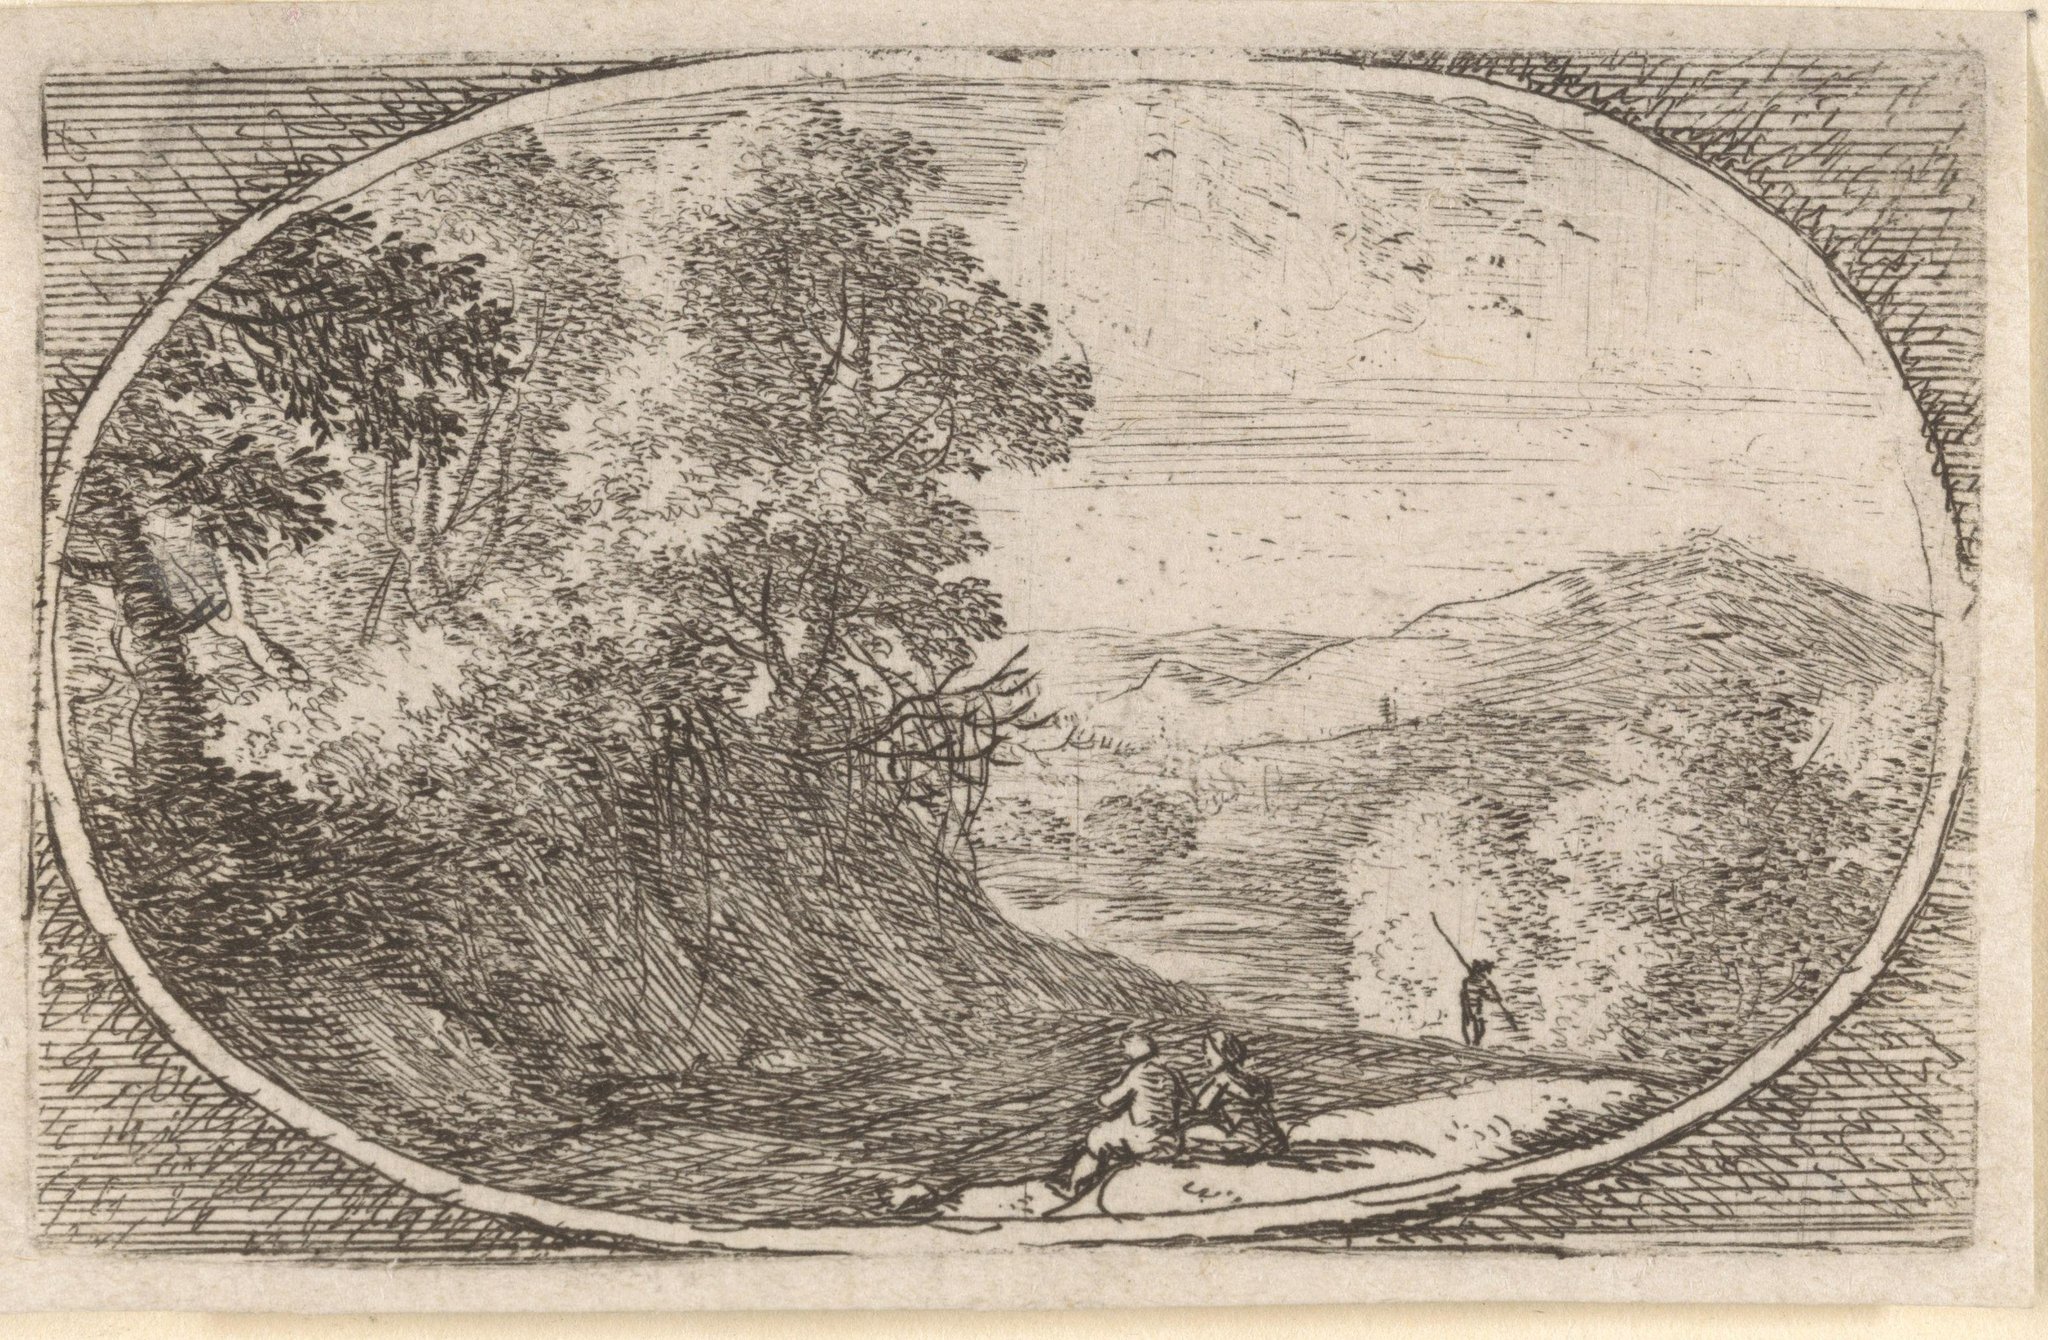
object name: print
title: Variae campestru fantasiae a Hermano van Suanevelt invent et in lucem edita (...)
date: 1650-1655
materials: paper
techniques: etching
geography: paris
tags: landscapes, (high) hill, sitting on the ground, 'en route', traveller under way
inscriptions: collector's mark: Lugt 240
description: In een ovale omlijsting zitten twee figuren langs de kant van een landweg. Aan de overkant staan bomen en in de verte loopt een derde figuur in de richting van de heuvels.